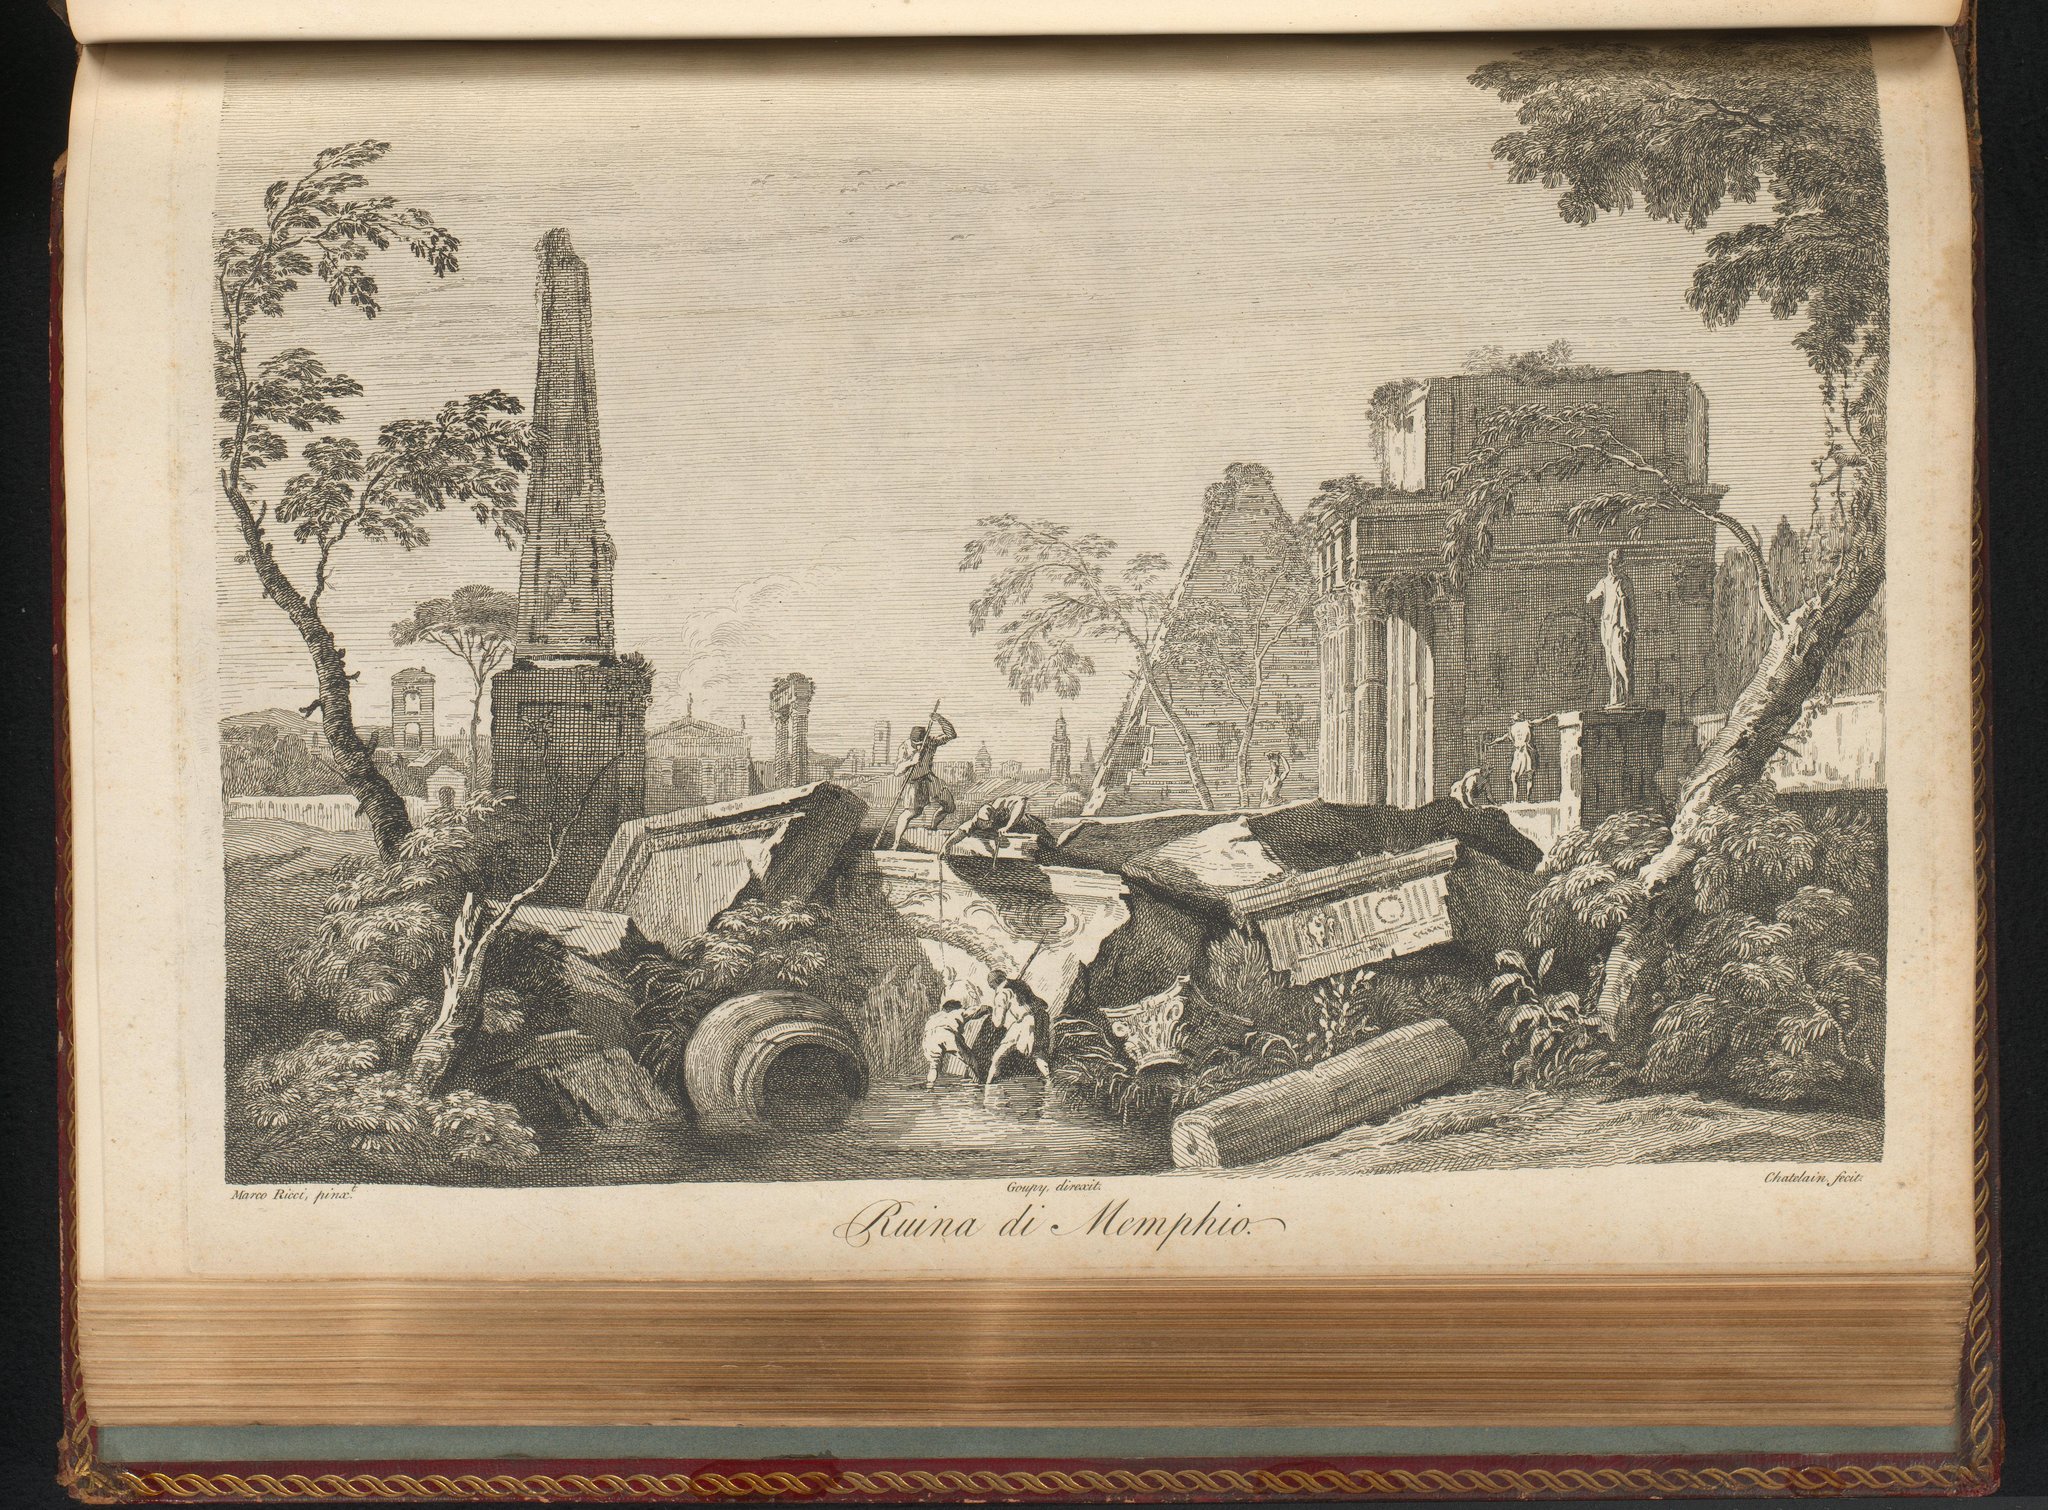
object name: album leaf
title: Ruïnes van Memphis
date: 1740-1771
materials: paper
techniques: etching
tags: landscape with ruins (+ city(-scape) with figures, staffage)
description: De samensteller heeft deze prent in het album ingevoegd als illustratie bij: Pilkington, Matthew en Johann Heinrich Füssli. A dictionary of painters, from the revival of the art to the present period. 4 dln. Londen: John Crowder, 1805, dl. 3, p. 410.